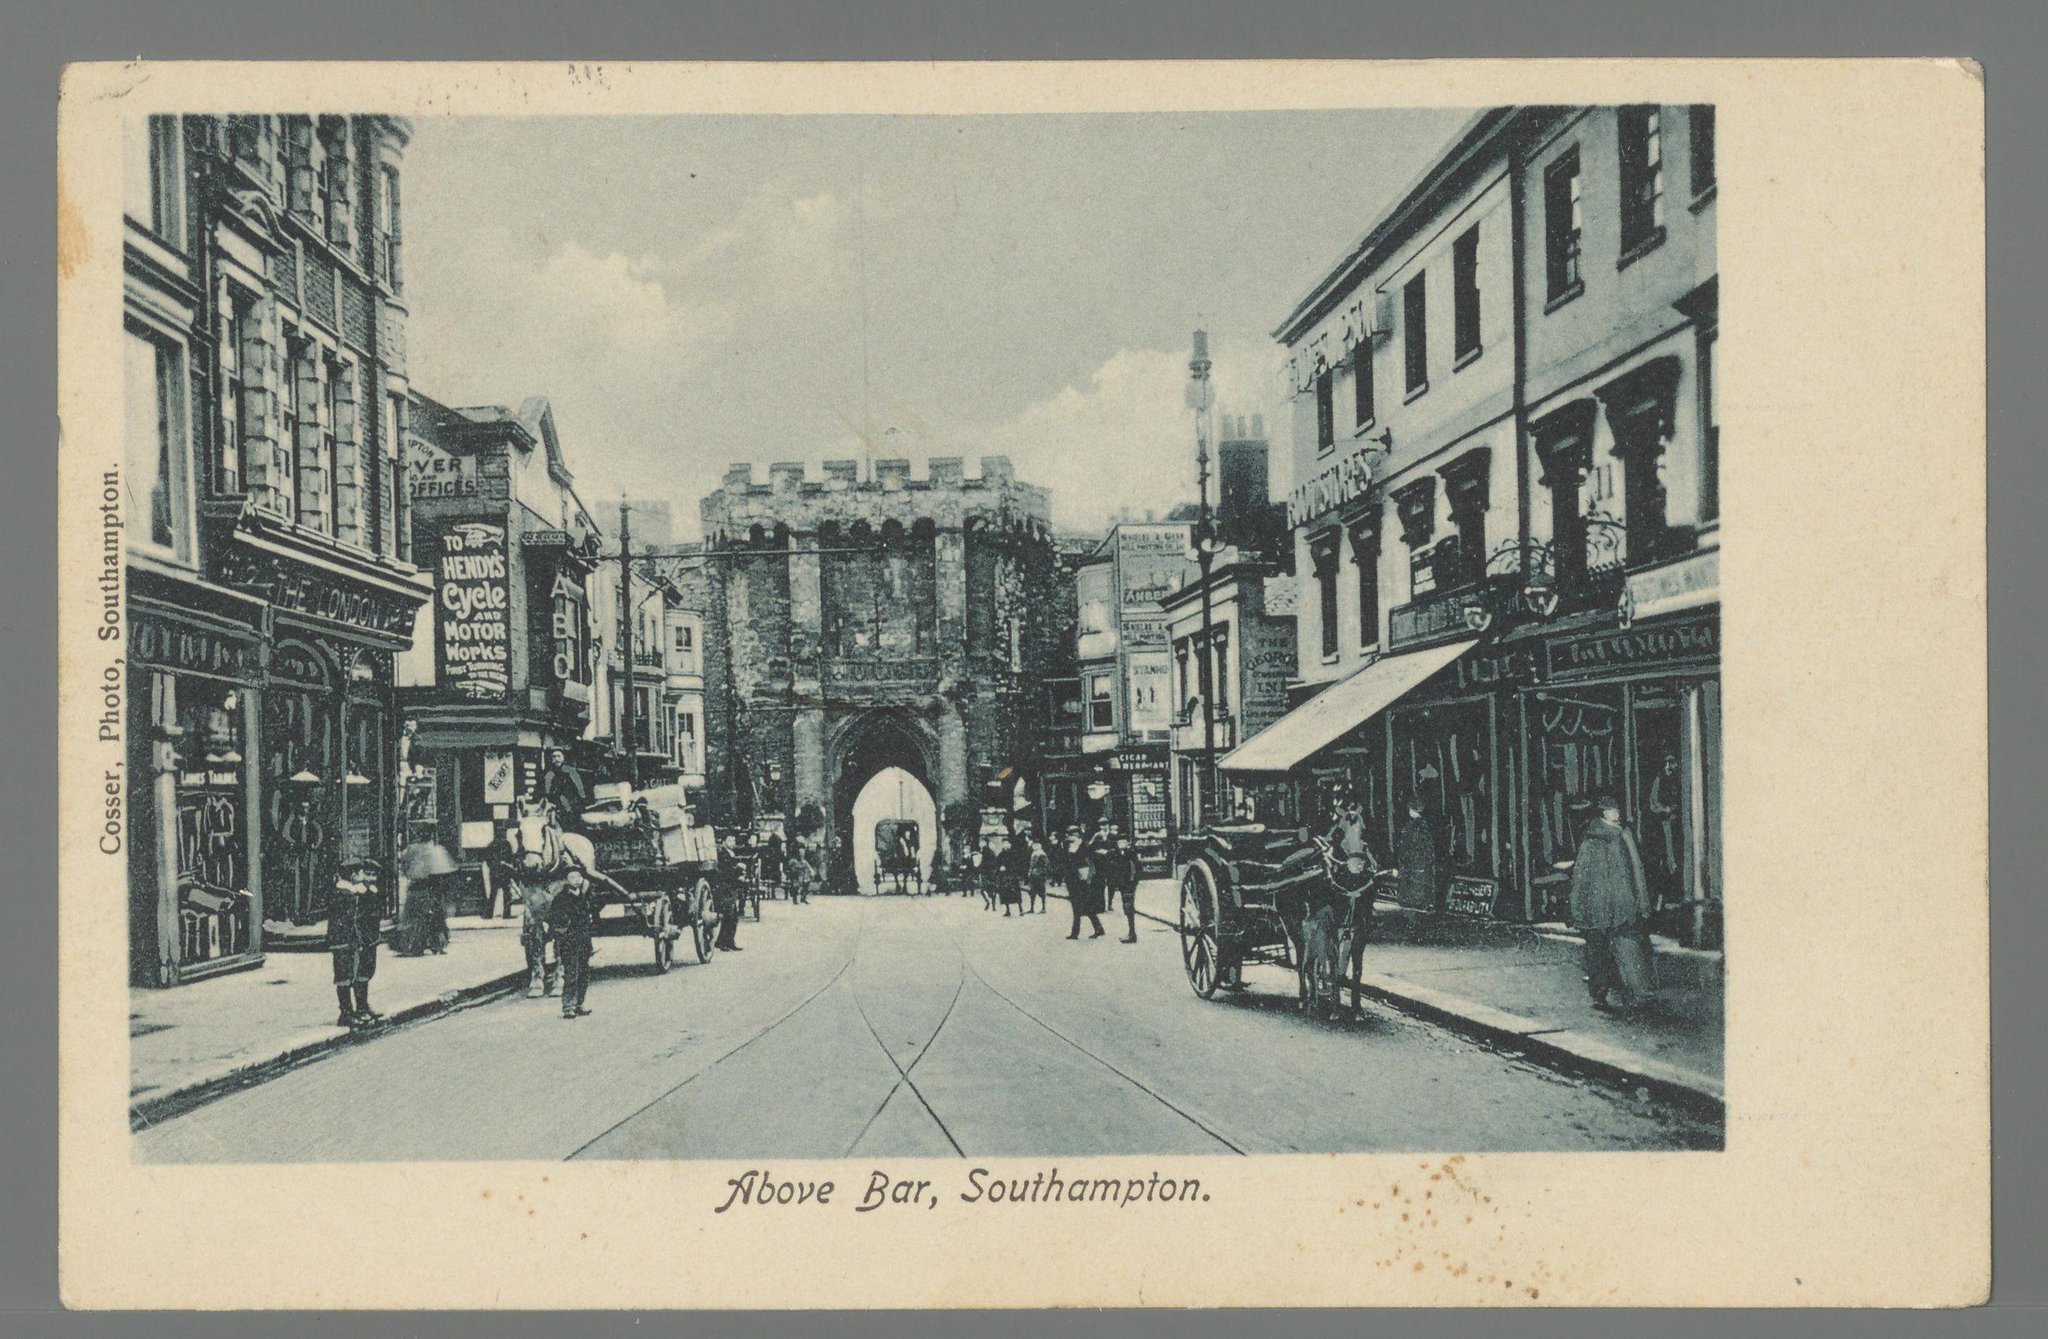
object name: photomechanical print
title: Above Bar, Southampton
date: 1902-1908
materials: cardboard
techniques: photograph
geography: southampton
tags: gate, entrance, street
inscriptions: poststempel, verso, gestempeld